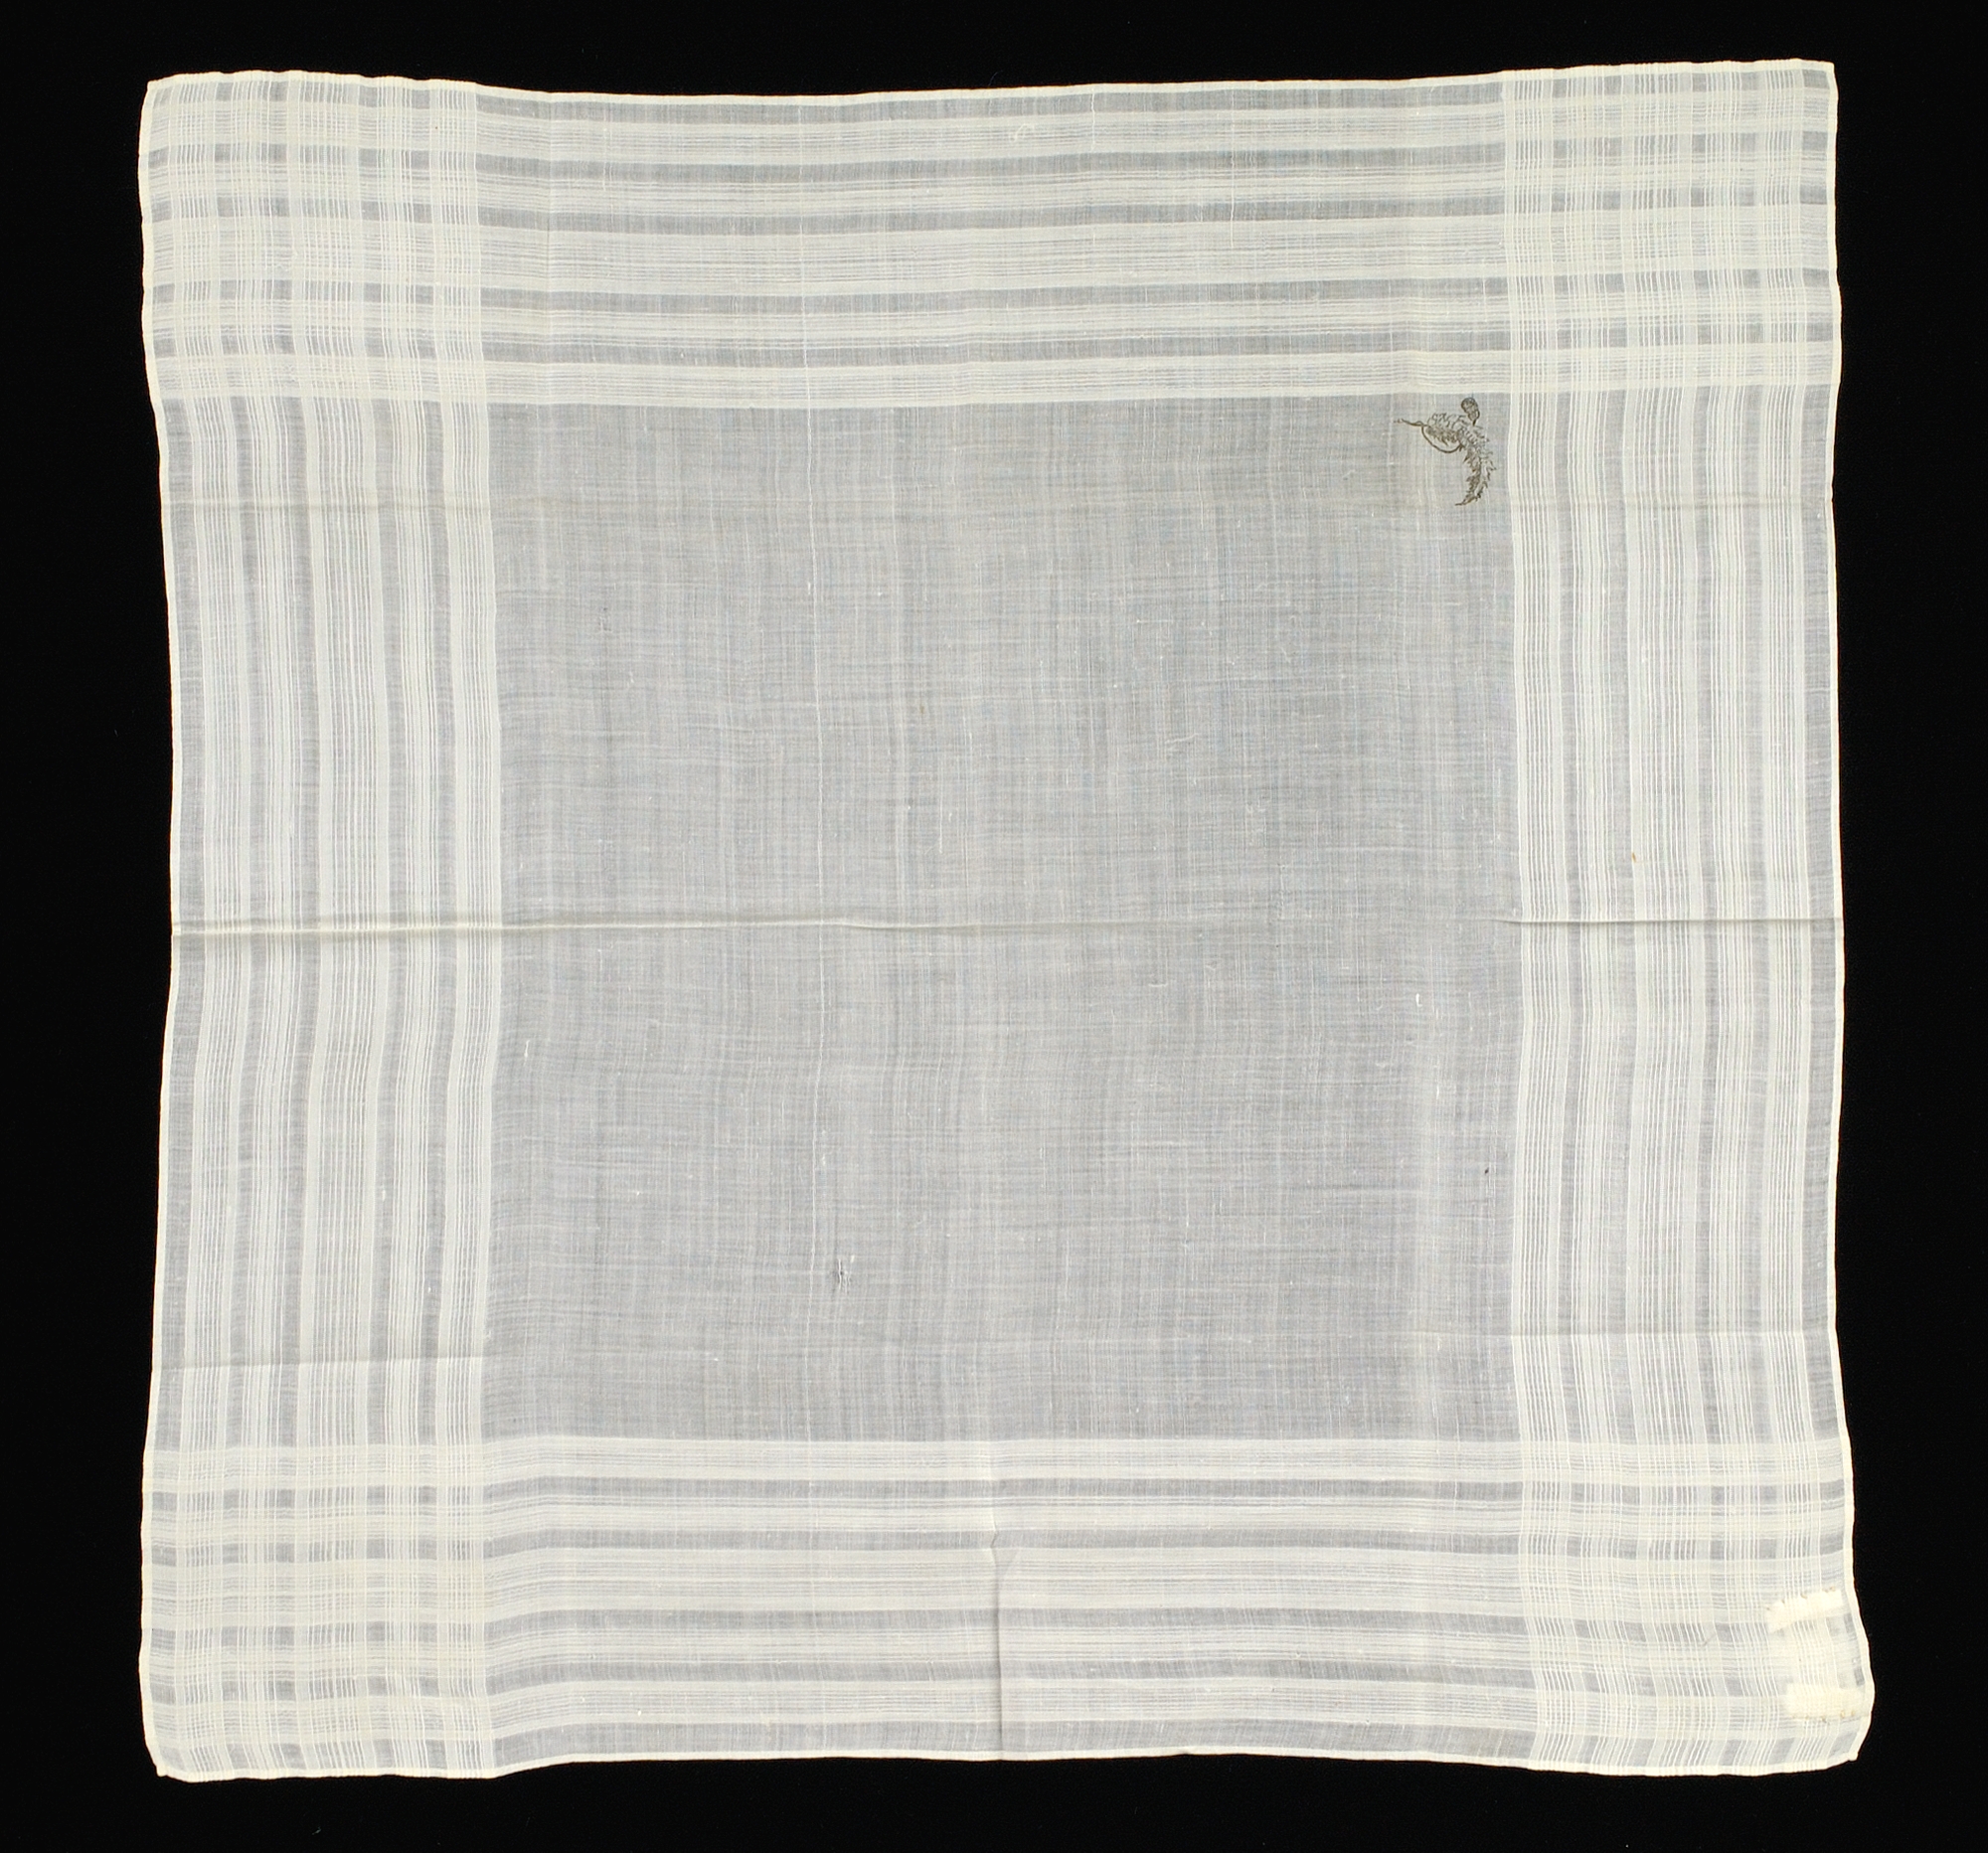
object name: handkerchief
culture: american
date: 1840-1860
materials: linen